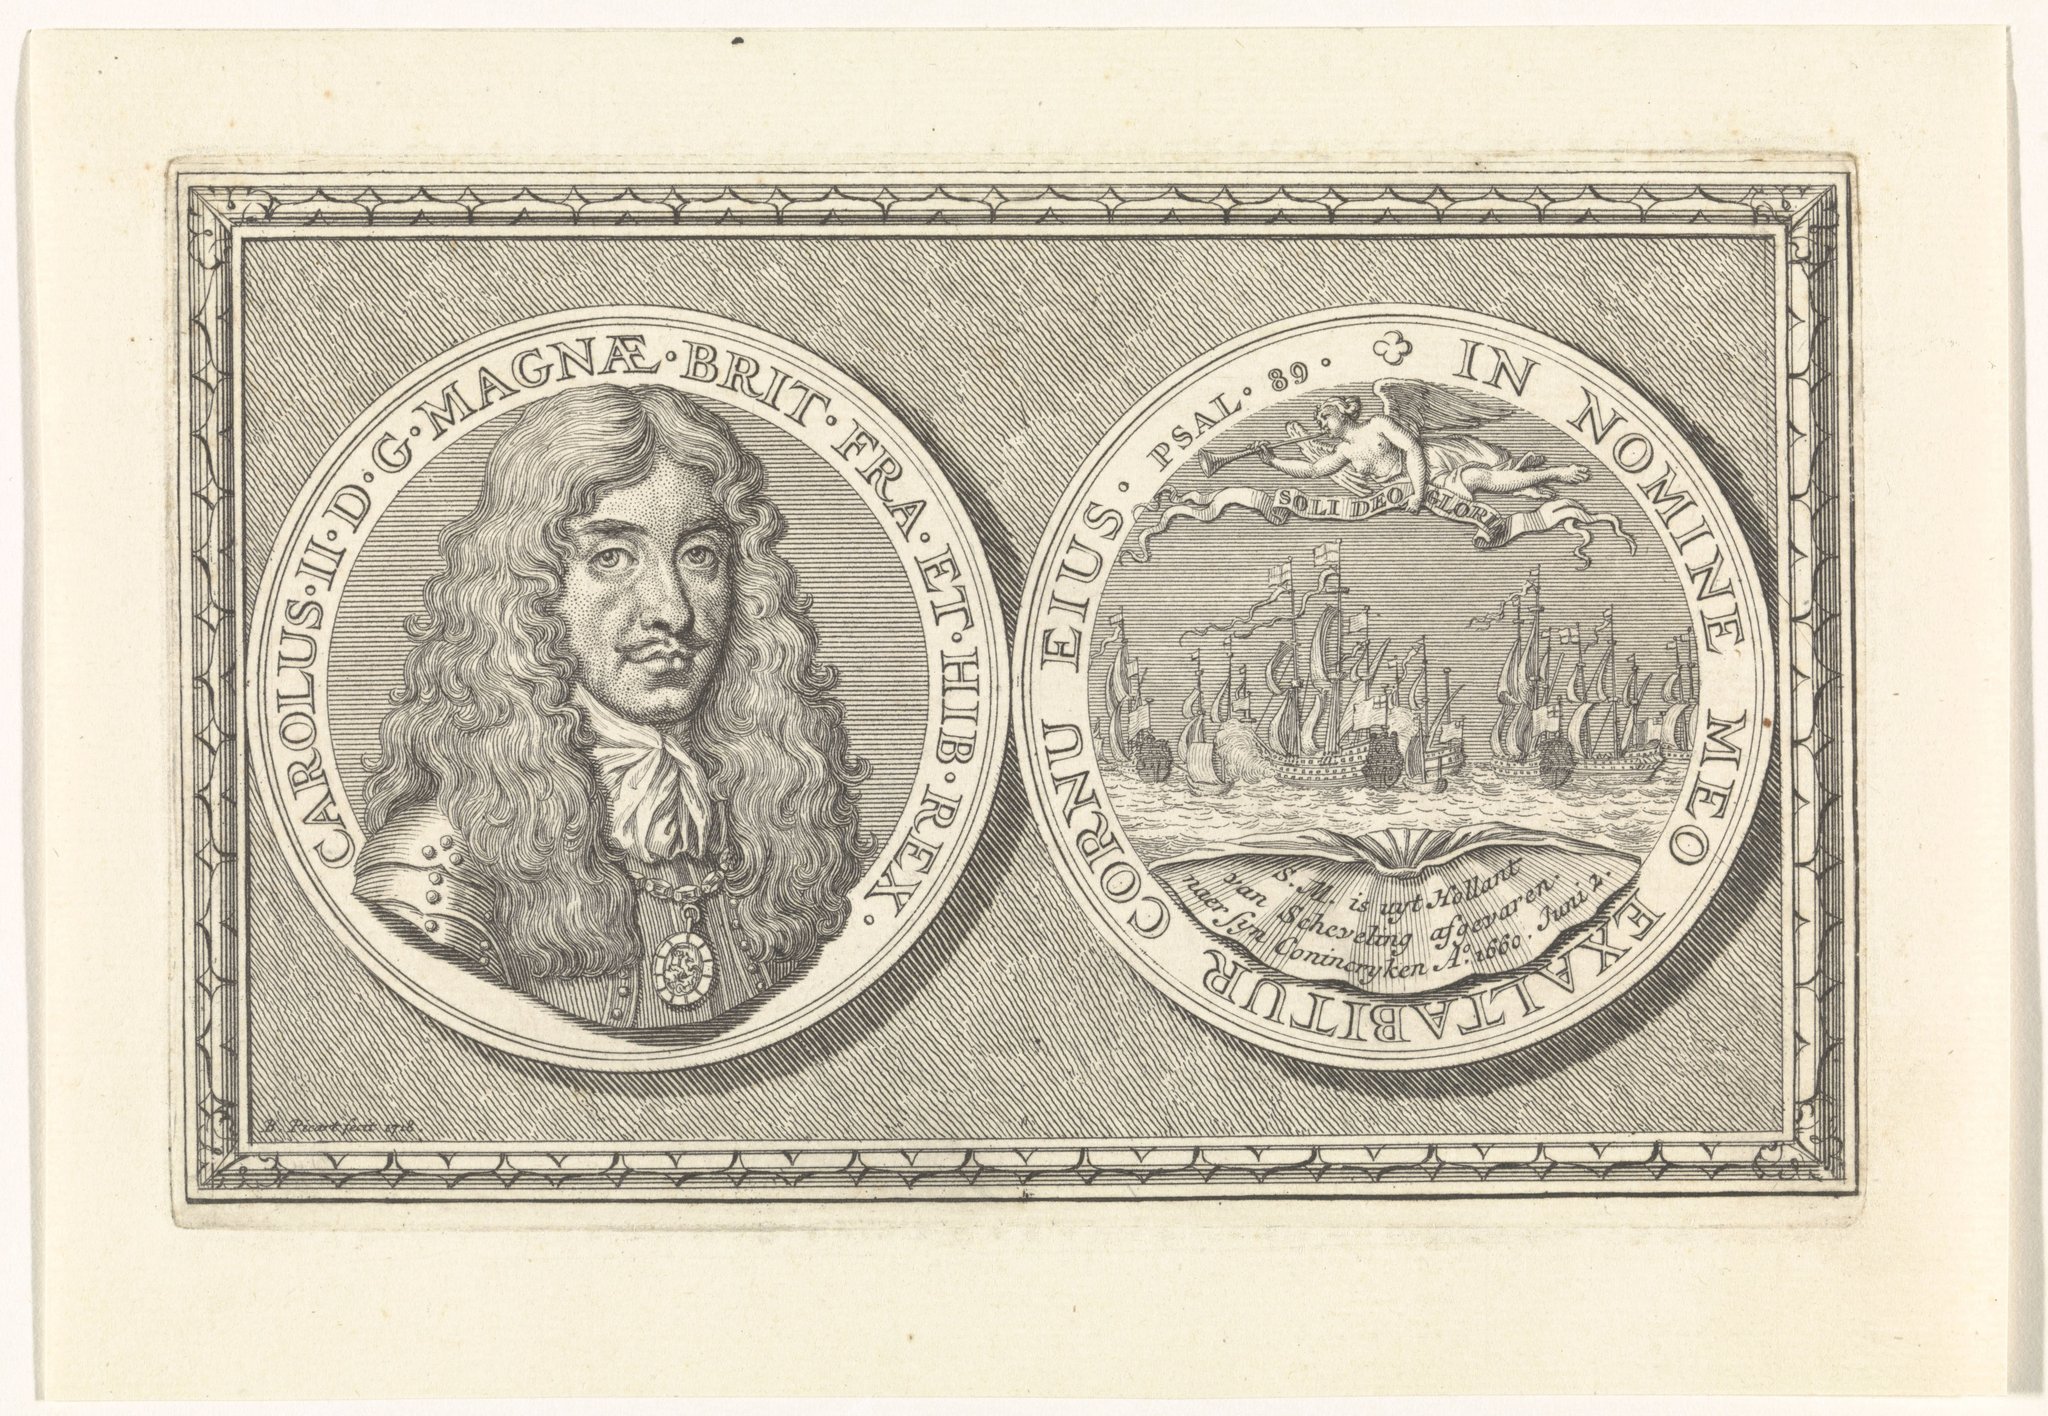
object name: print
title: Penning met het portret van Karel II van Engeland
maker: bernard picart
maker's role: draughtsman, print maker, publisher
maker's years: 1673-1733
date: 1718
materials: paper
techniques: engraving, etching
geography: amsterdam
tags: london, karel ii (koning van engeland), medal (considered as a piece of sculpture, regardless of its specific function)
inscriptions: collector's mark: Lugt 2228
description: Penning met het portret van Karel II, koning van Engeland. Op de andere zijde het vertrek van de koning vanuit Scheveningen naar Engeland, op 2 juni 1660.